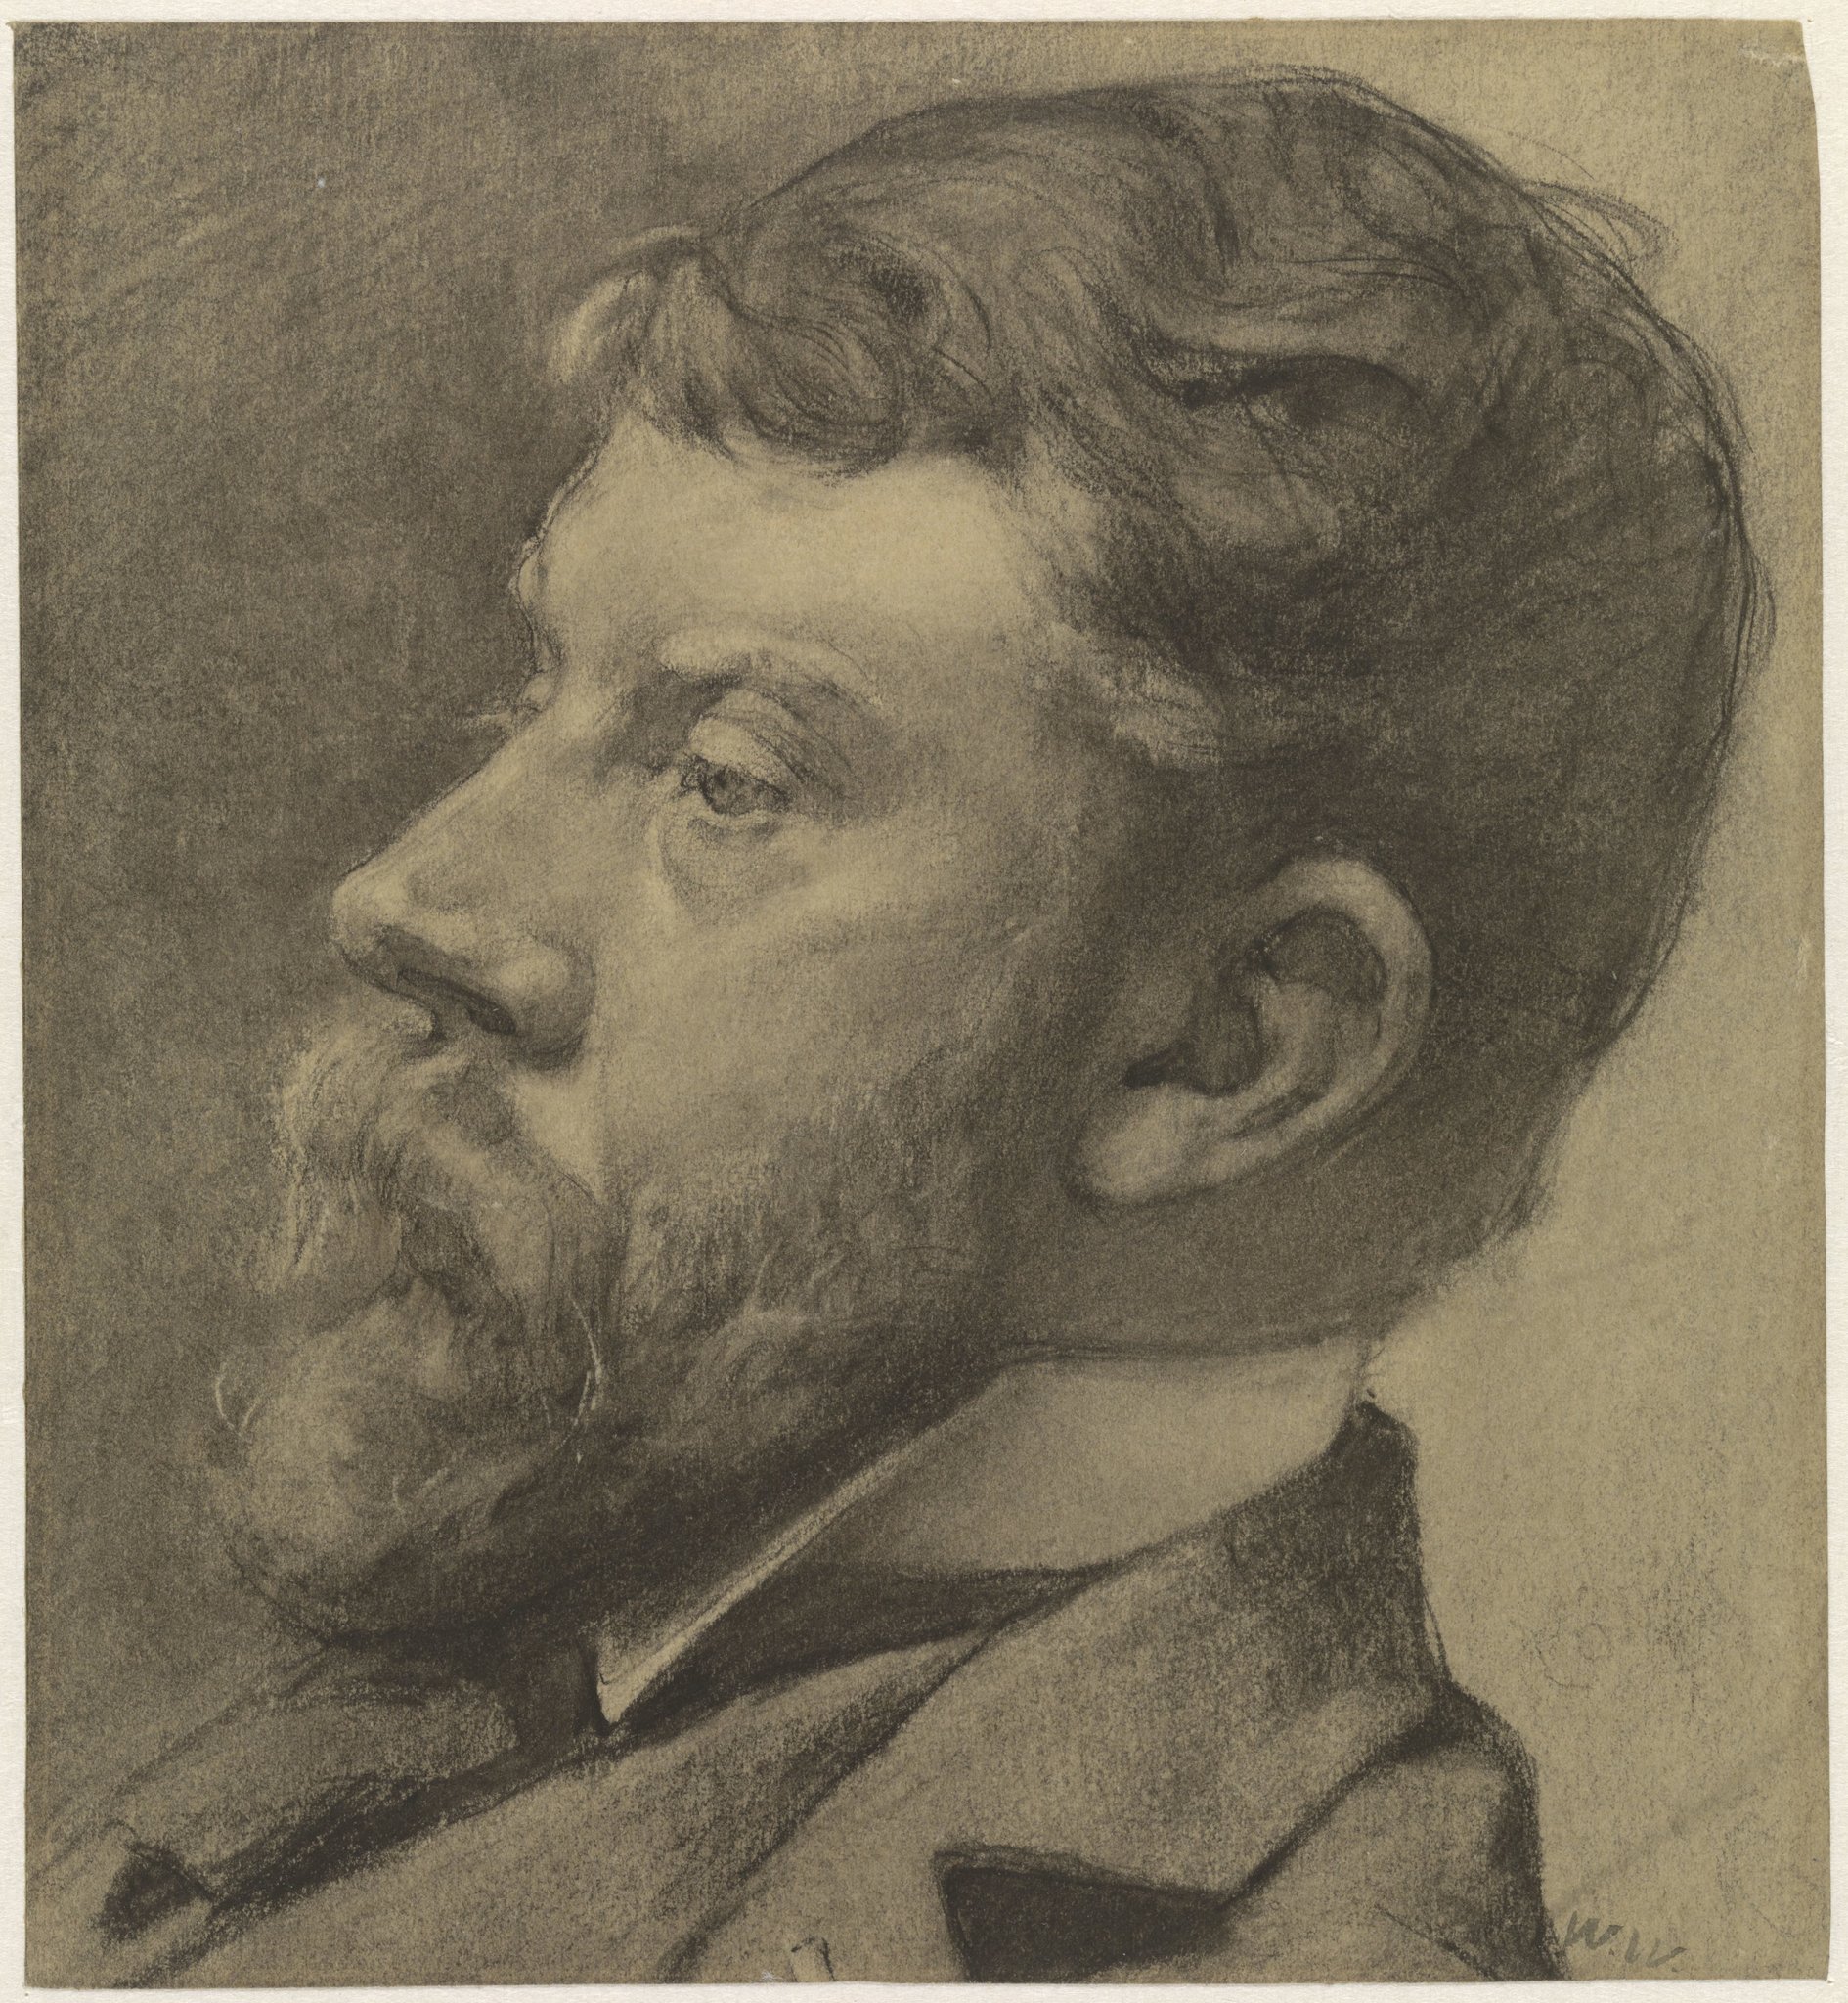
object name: drawing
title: Portret van George Hendrik Breitner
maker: willem witsen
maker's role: draughtsman, painter, print maker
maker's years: 1860-1923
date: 1887-1923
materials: chalk, charcoal, paper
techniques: brush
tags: rotterdam, george hendrik breitner, historical persons, portrait, self-portrait of painter, portrait, self-portrait of artist, portrait, self-portrait of draughtsman